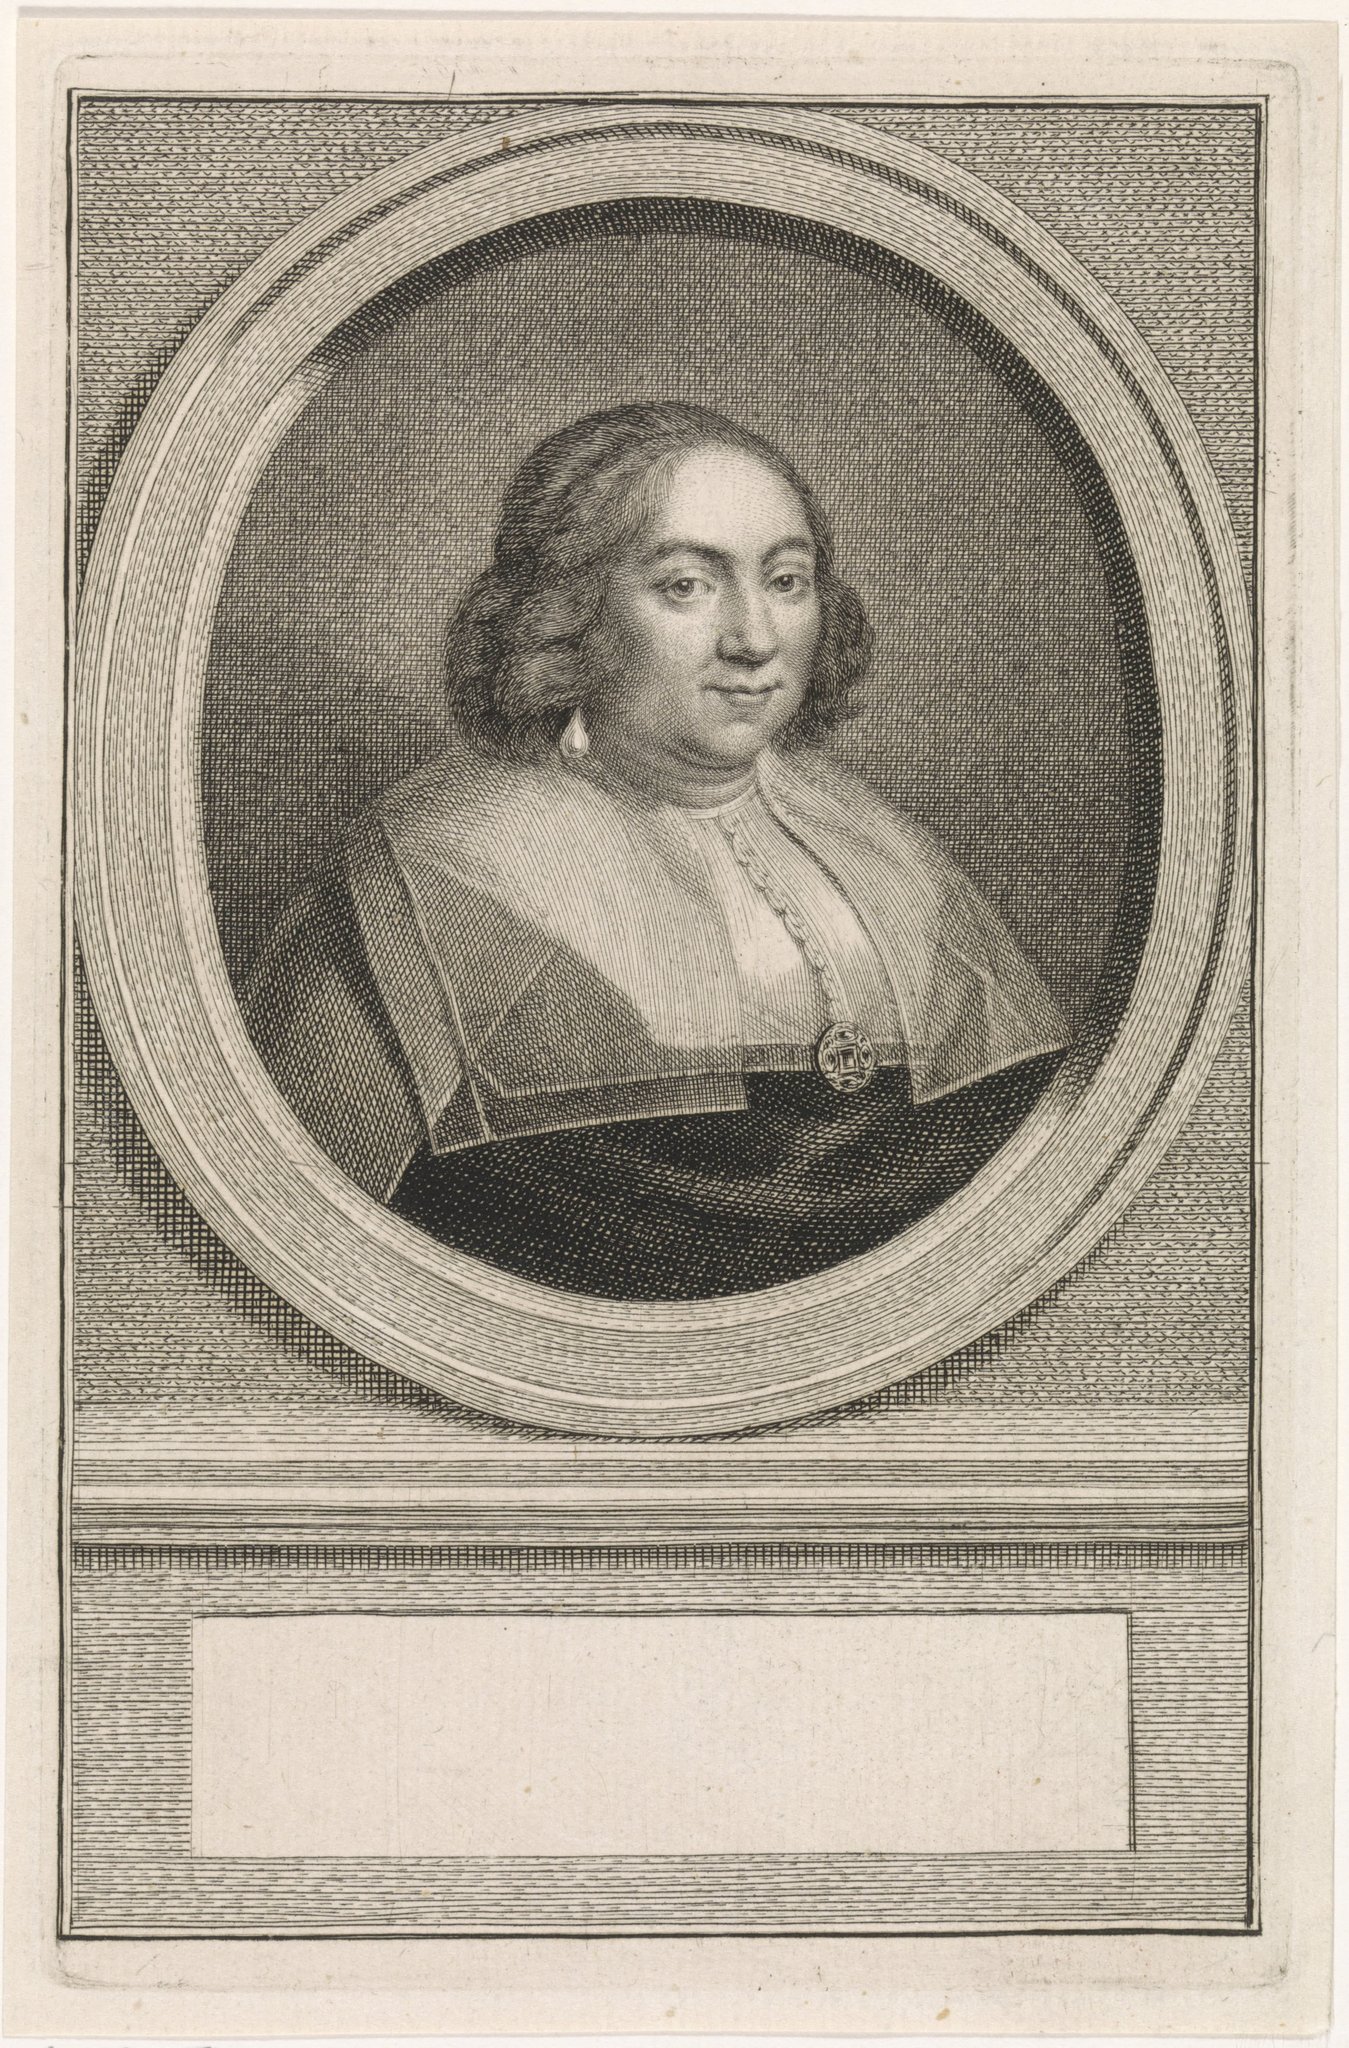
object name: print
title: Portret van Maria van Reigersberch (1589-1653)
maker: jacob houbraken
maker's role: draughtsman, print maker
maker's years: 1698-1780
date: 1708-1780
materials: paper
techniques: engraving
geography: amsterdam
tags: the hague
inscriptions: collector's mark: Lugt 240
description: Buste naar rechts van Maria van Reigersberch in een ovaal. Het portret rust op een richel waarop een leeg veld voor haar naam.